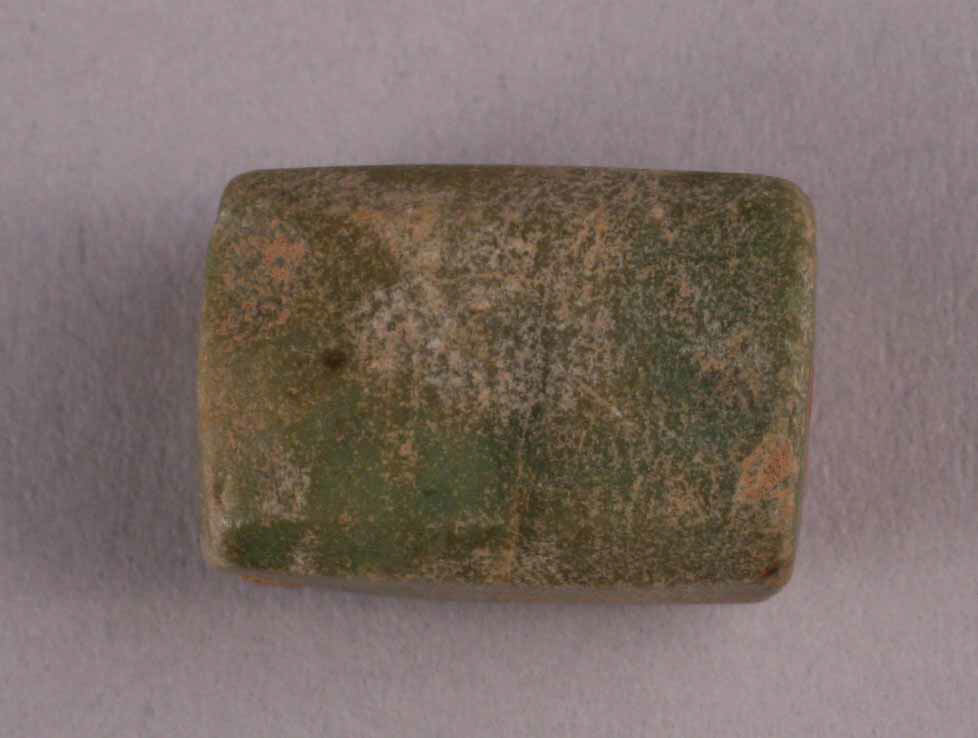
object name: gaming piece or stone object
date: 701-1300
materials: stone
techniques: carving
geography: iran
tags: games